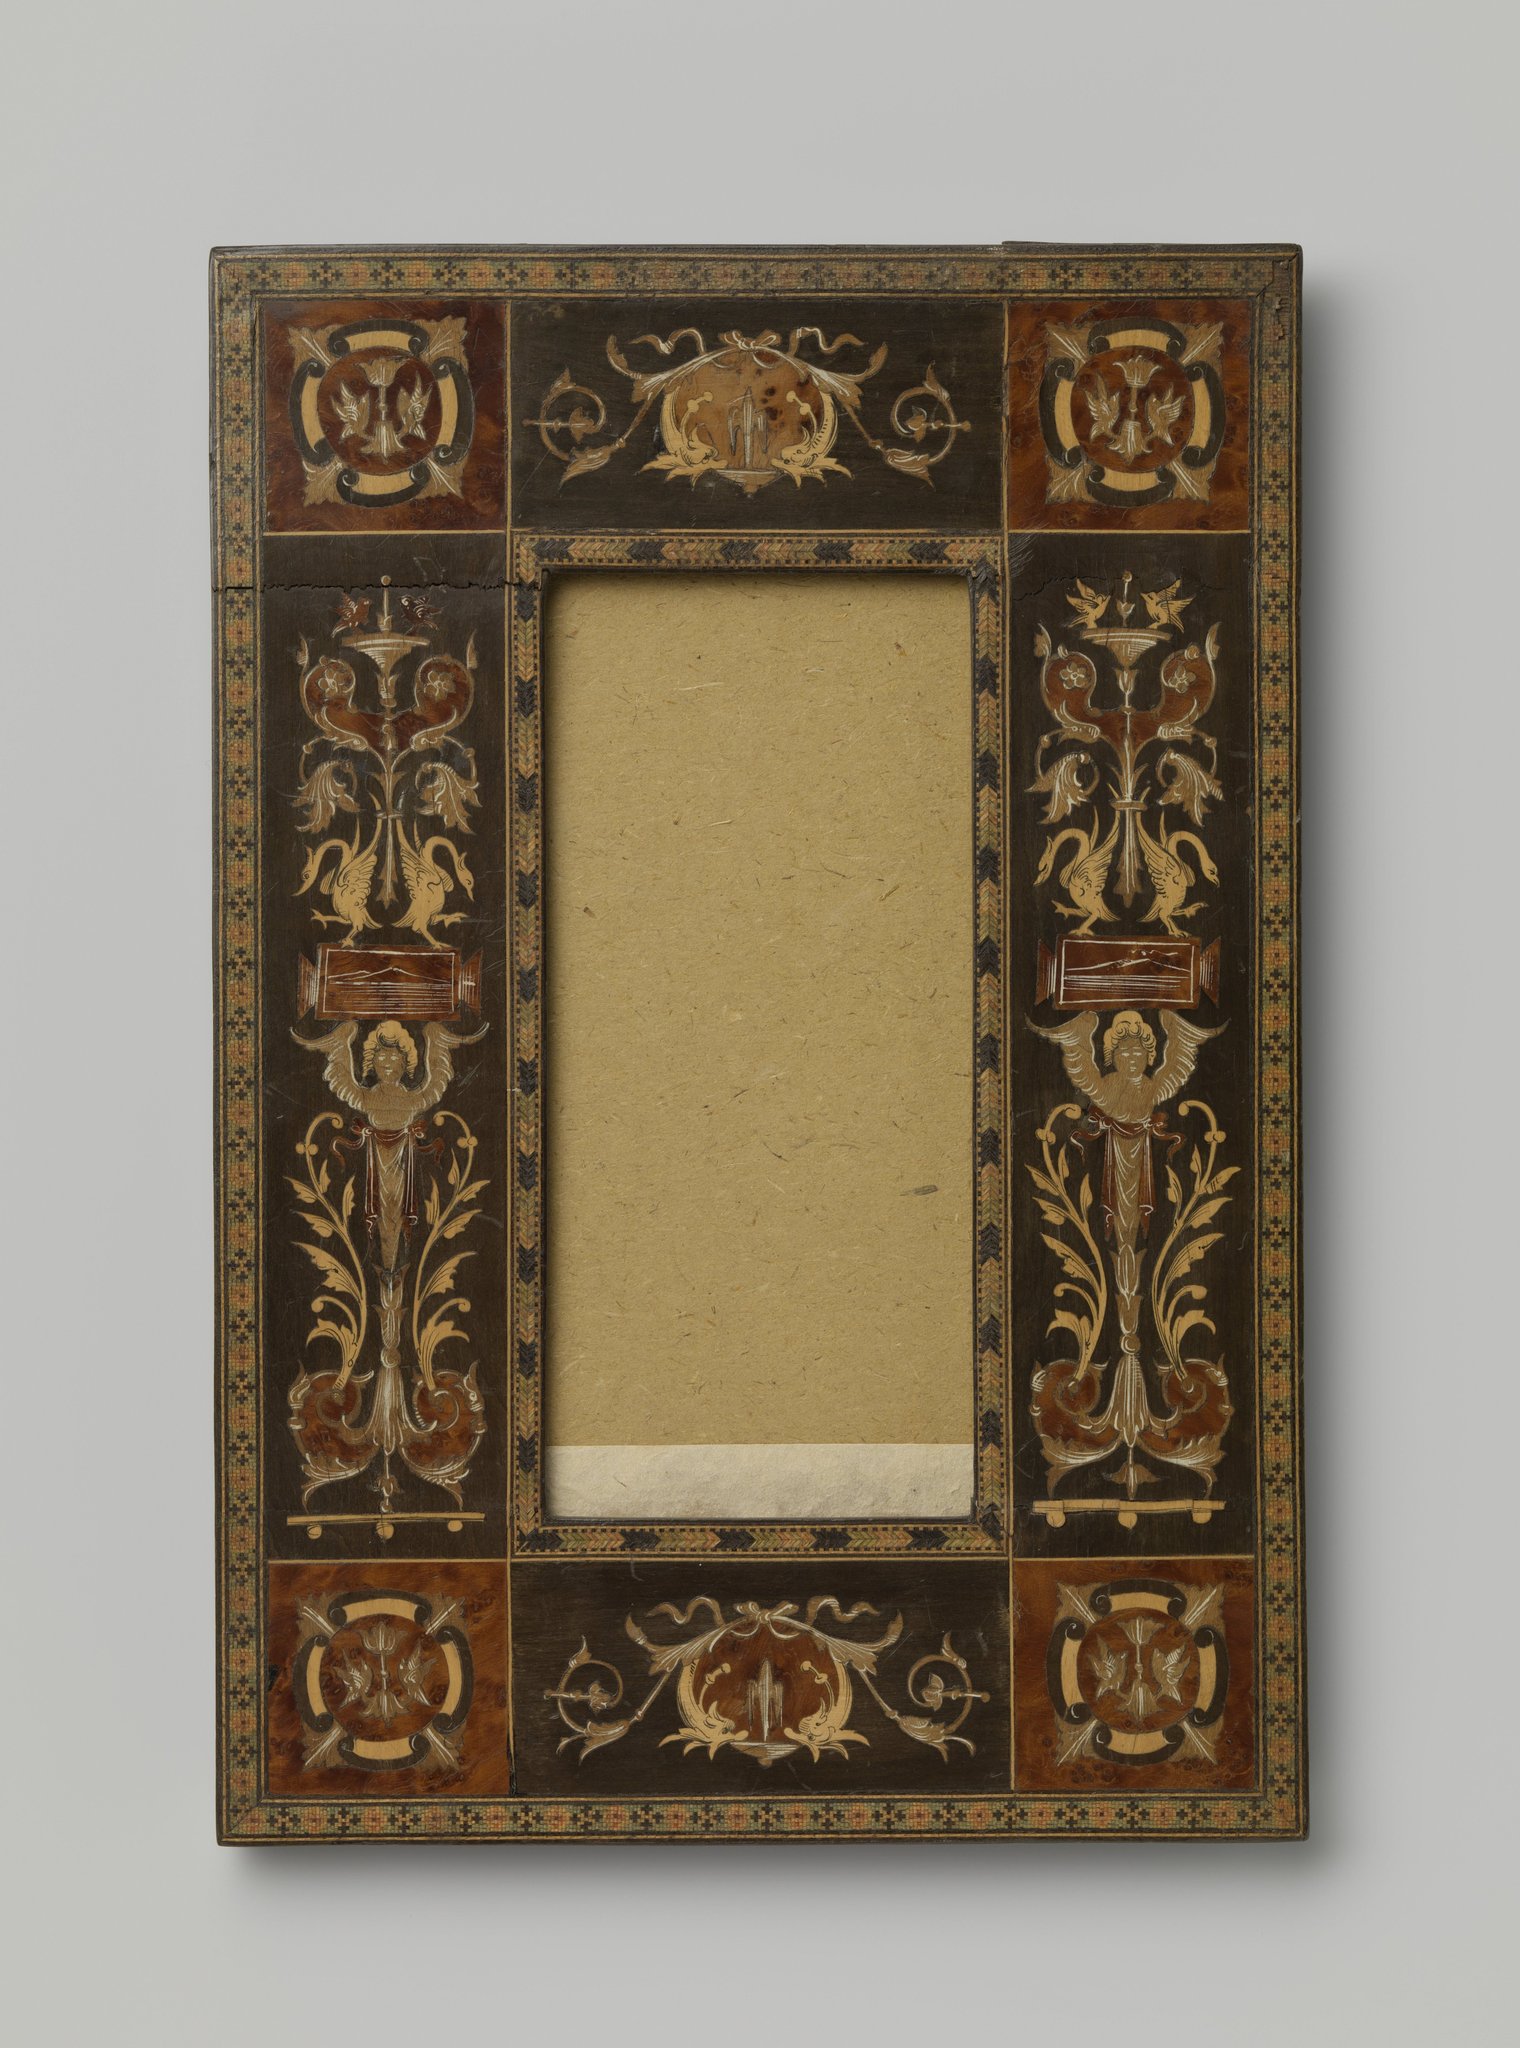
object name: frame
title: Lijst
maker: Anonymous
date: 1880-1900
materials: cardboard, glass, metal, wood